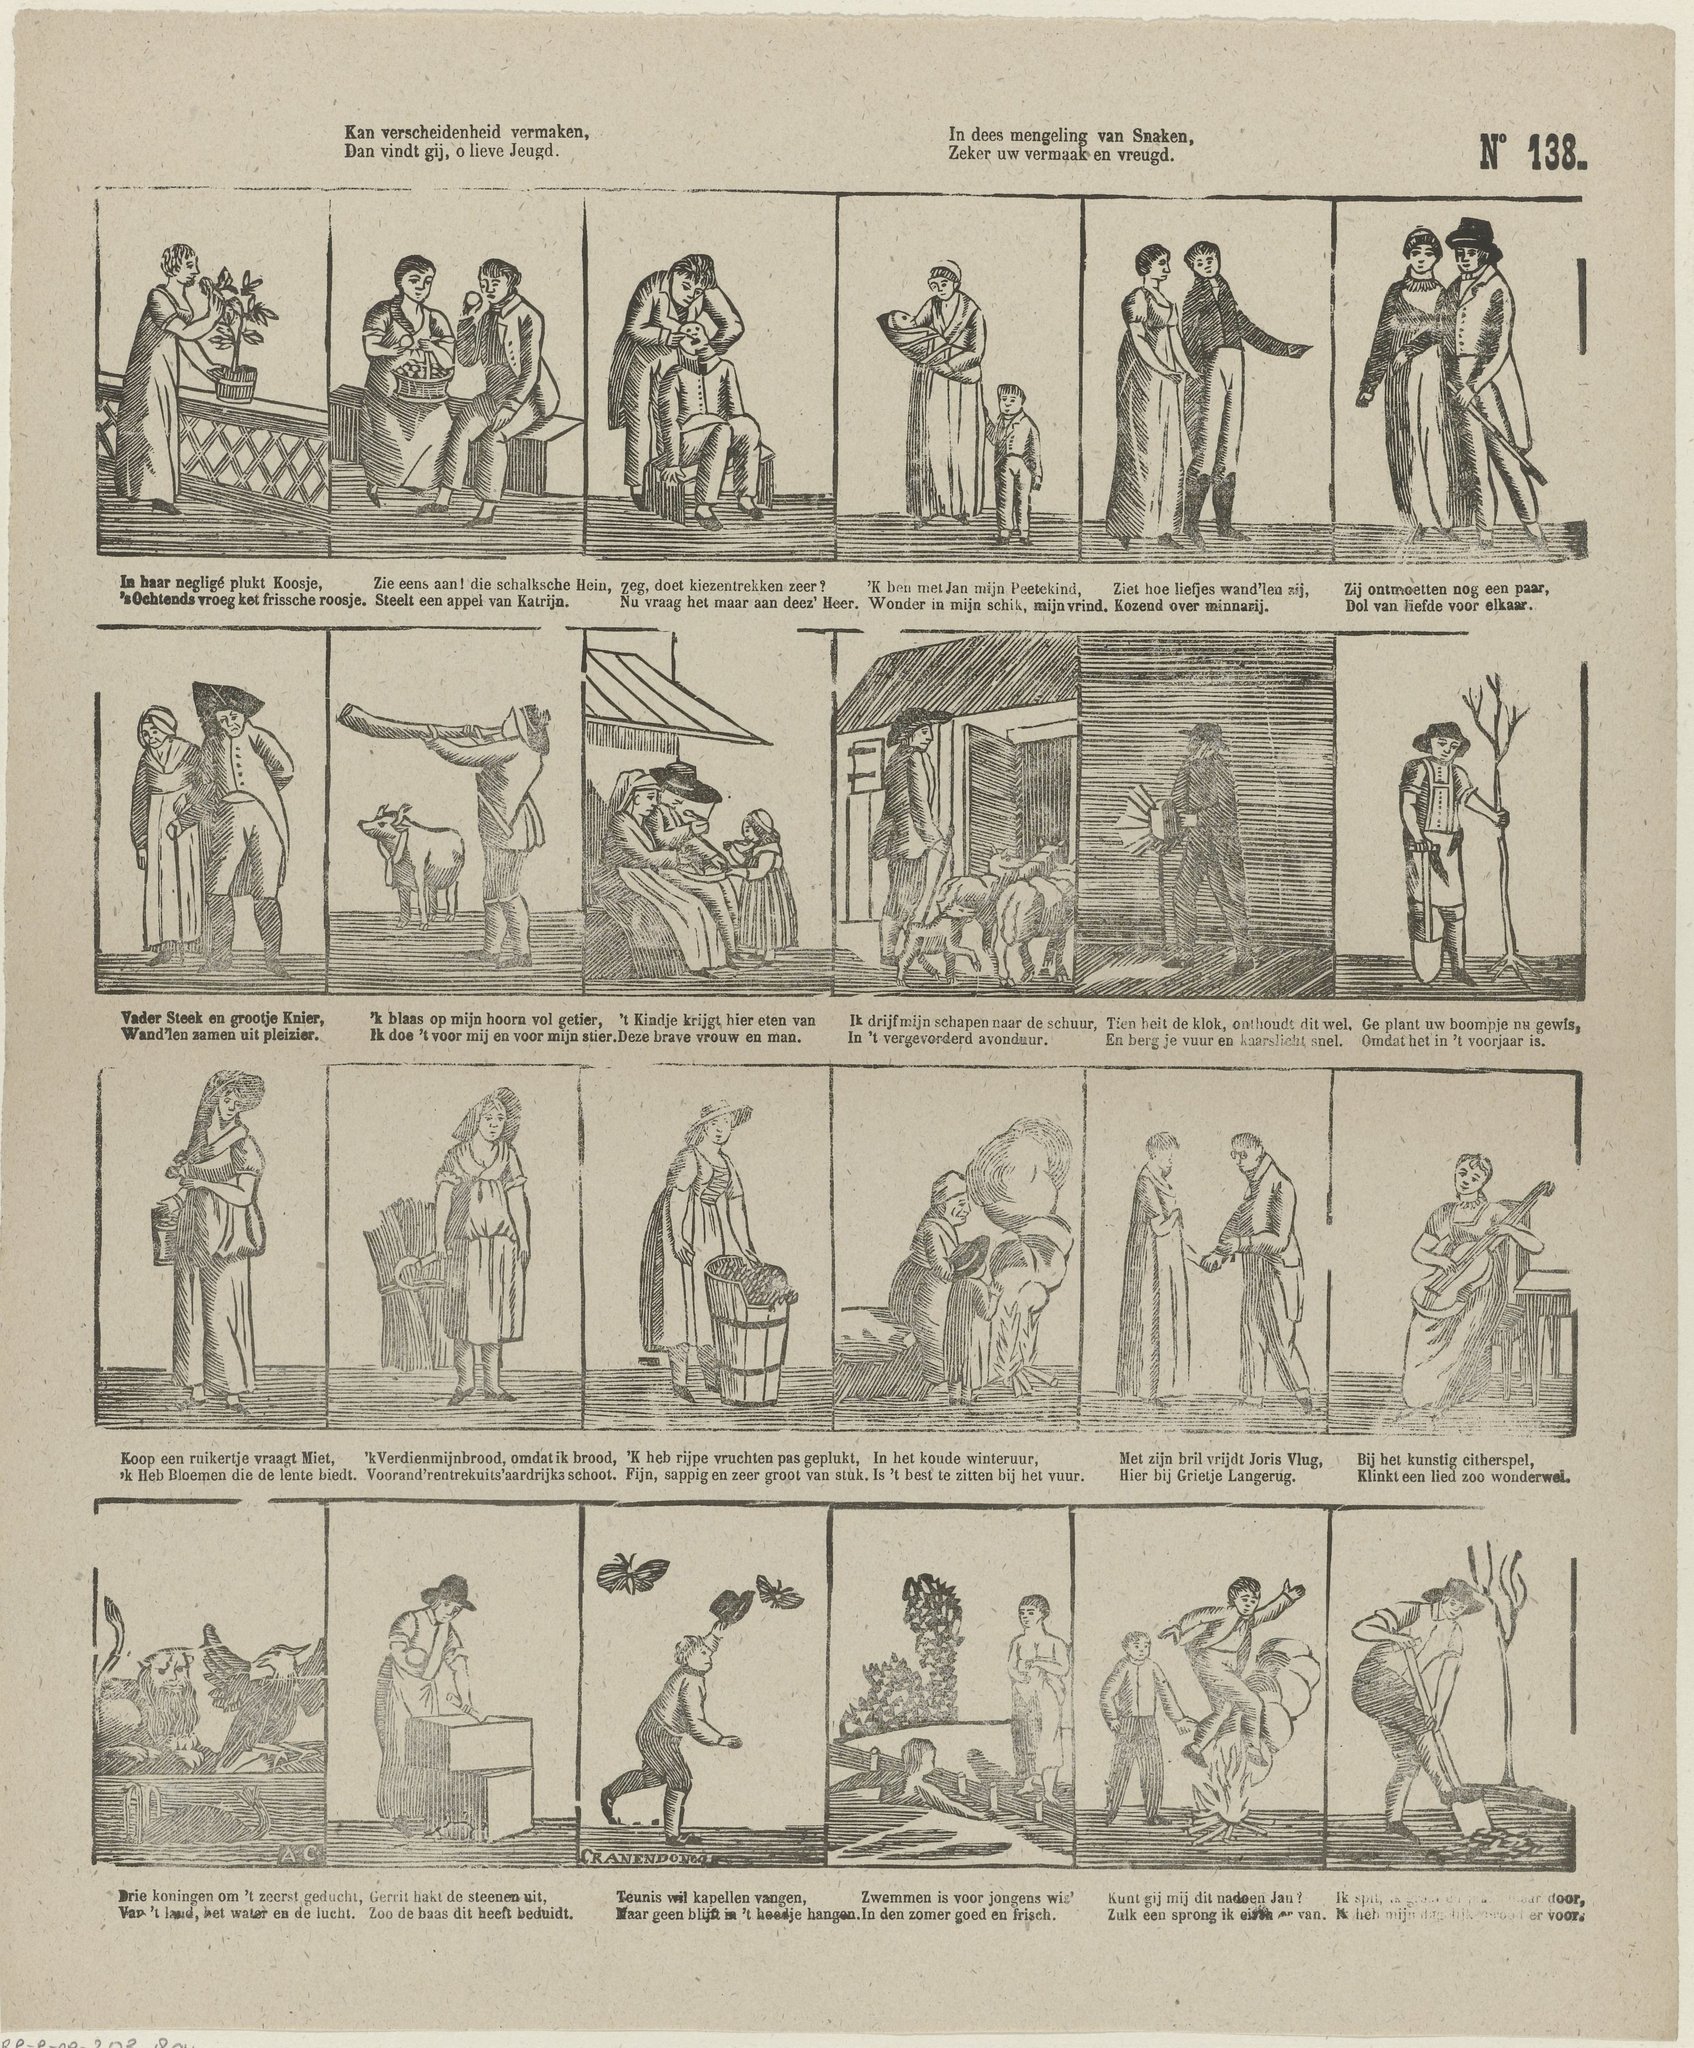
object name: print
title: Kan verscheidenheid vermaken, / Dan vindt gij, o lieve jeugd / In dees mengeling van snaken, / Zeker uw vermaak en vreugd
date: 1827-1894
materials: paper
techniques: letterpress printing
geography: schaarbeek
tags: characters (human types)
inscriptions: collector's mark: Lugt 2760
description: Blad met 24 voorstellingen van verschillende figuren en bezigheden. Onder elke afbeelding een tweeregelig vers. Genummerd rechtsboven: No 138.